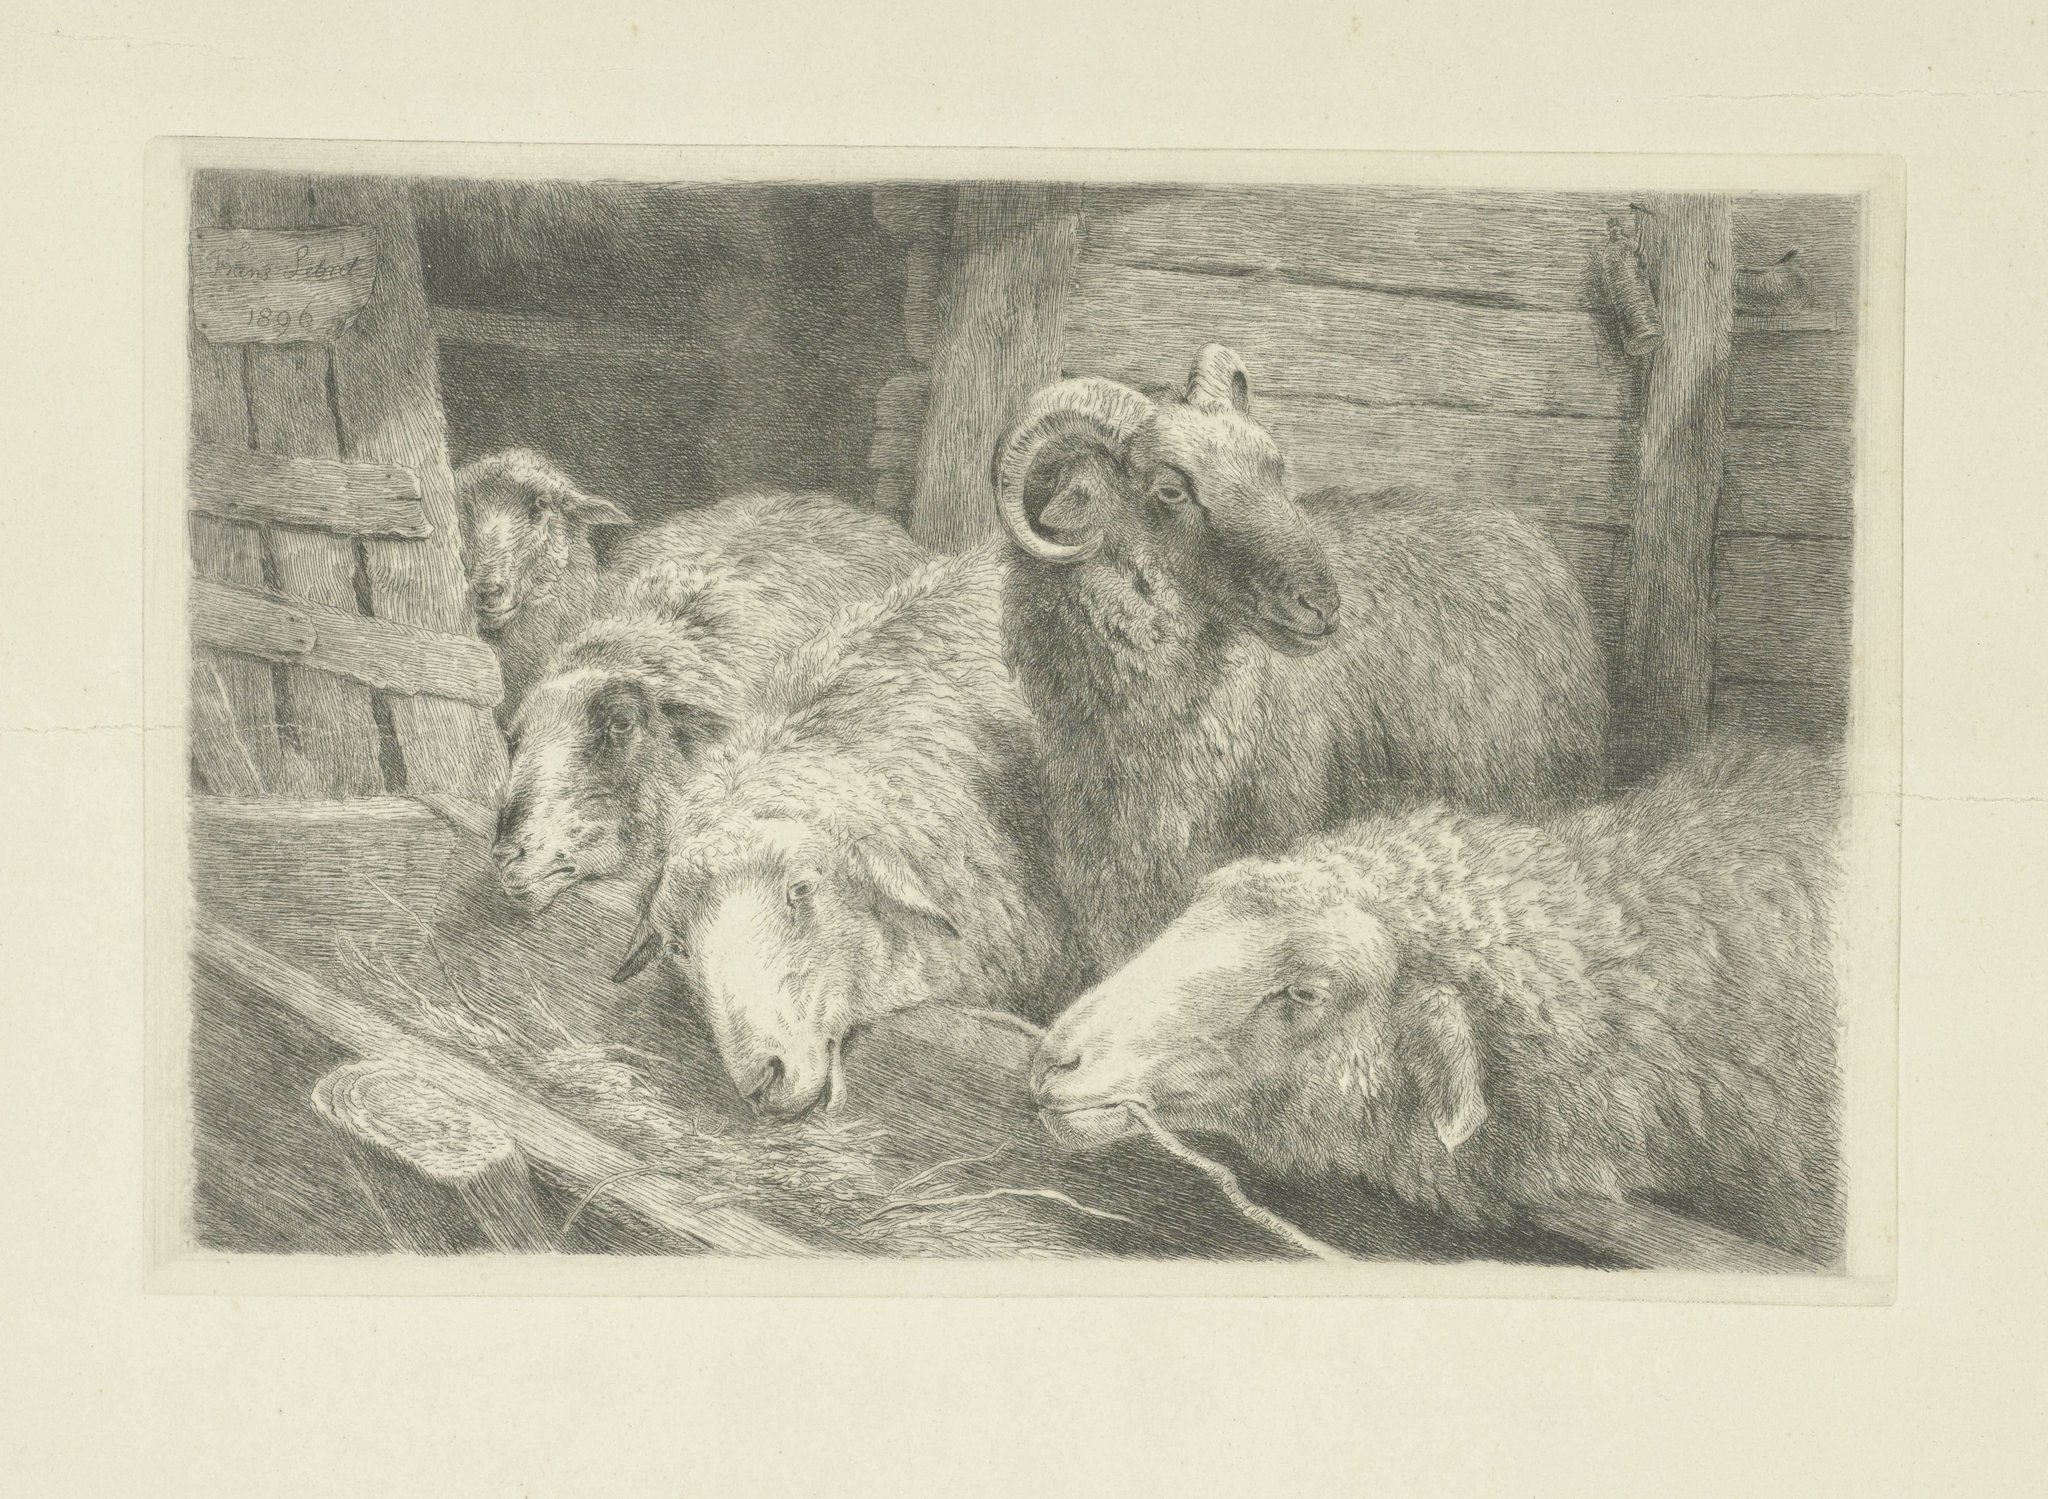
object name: print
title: Vier schapen en een ram voor een voederbak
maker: frans lebret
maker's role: draughtsman, painter, print maker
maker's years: 1820-1909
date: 1896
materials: paper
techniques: etching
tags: ram, sheep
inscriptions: collector's mark: Lugt 2228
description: Drie schapen en een ram eten voor een stal uit de voederbak, links staat bij de staldeur een vierde schaap.